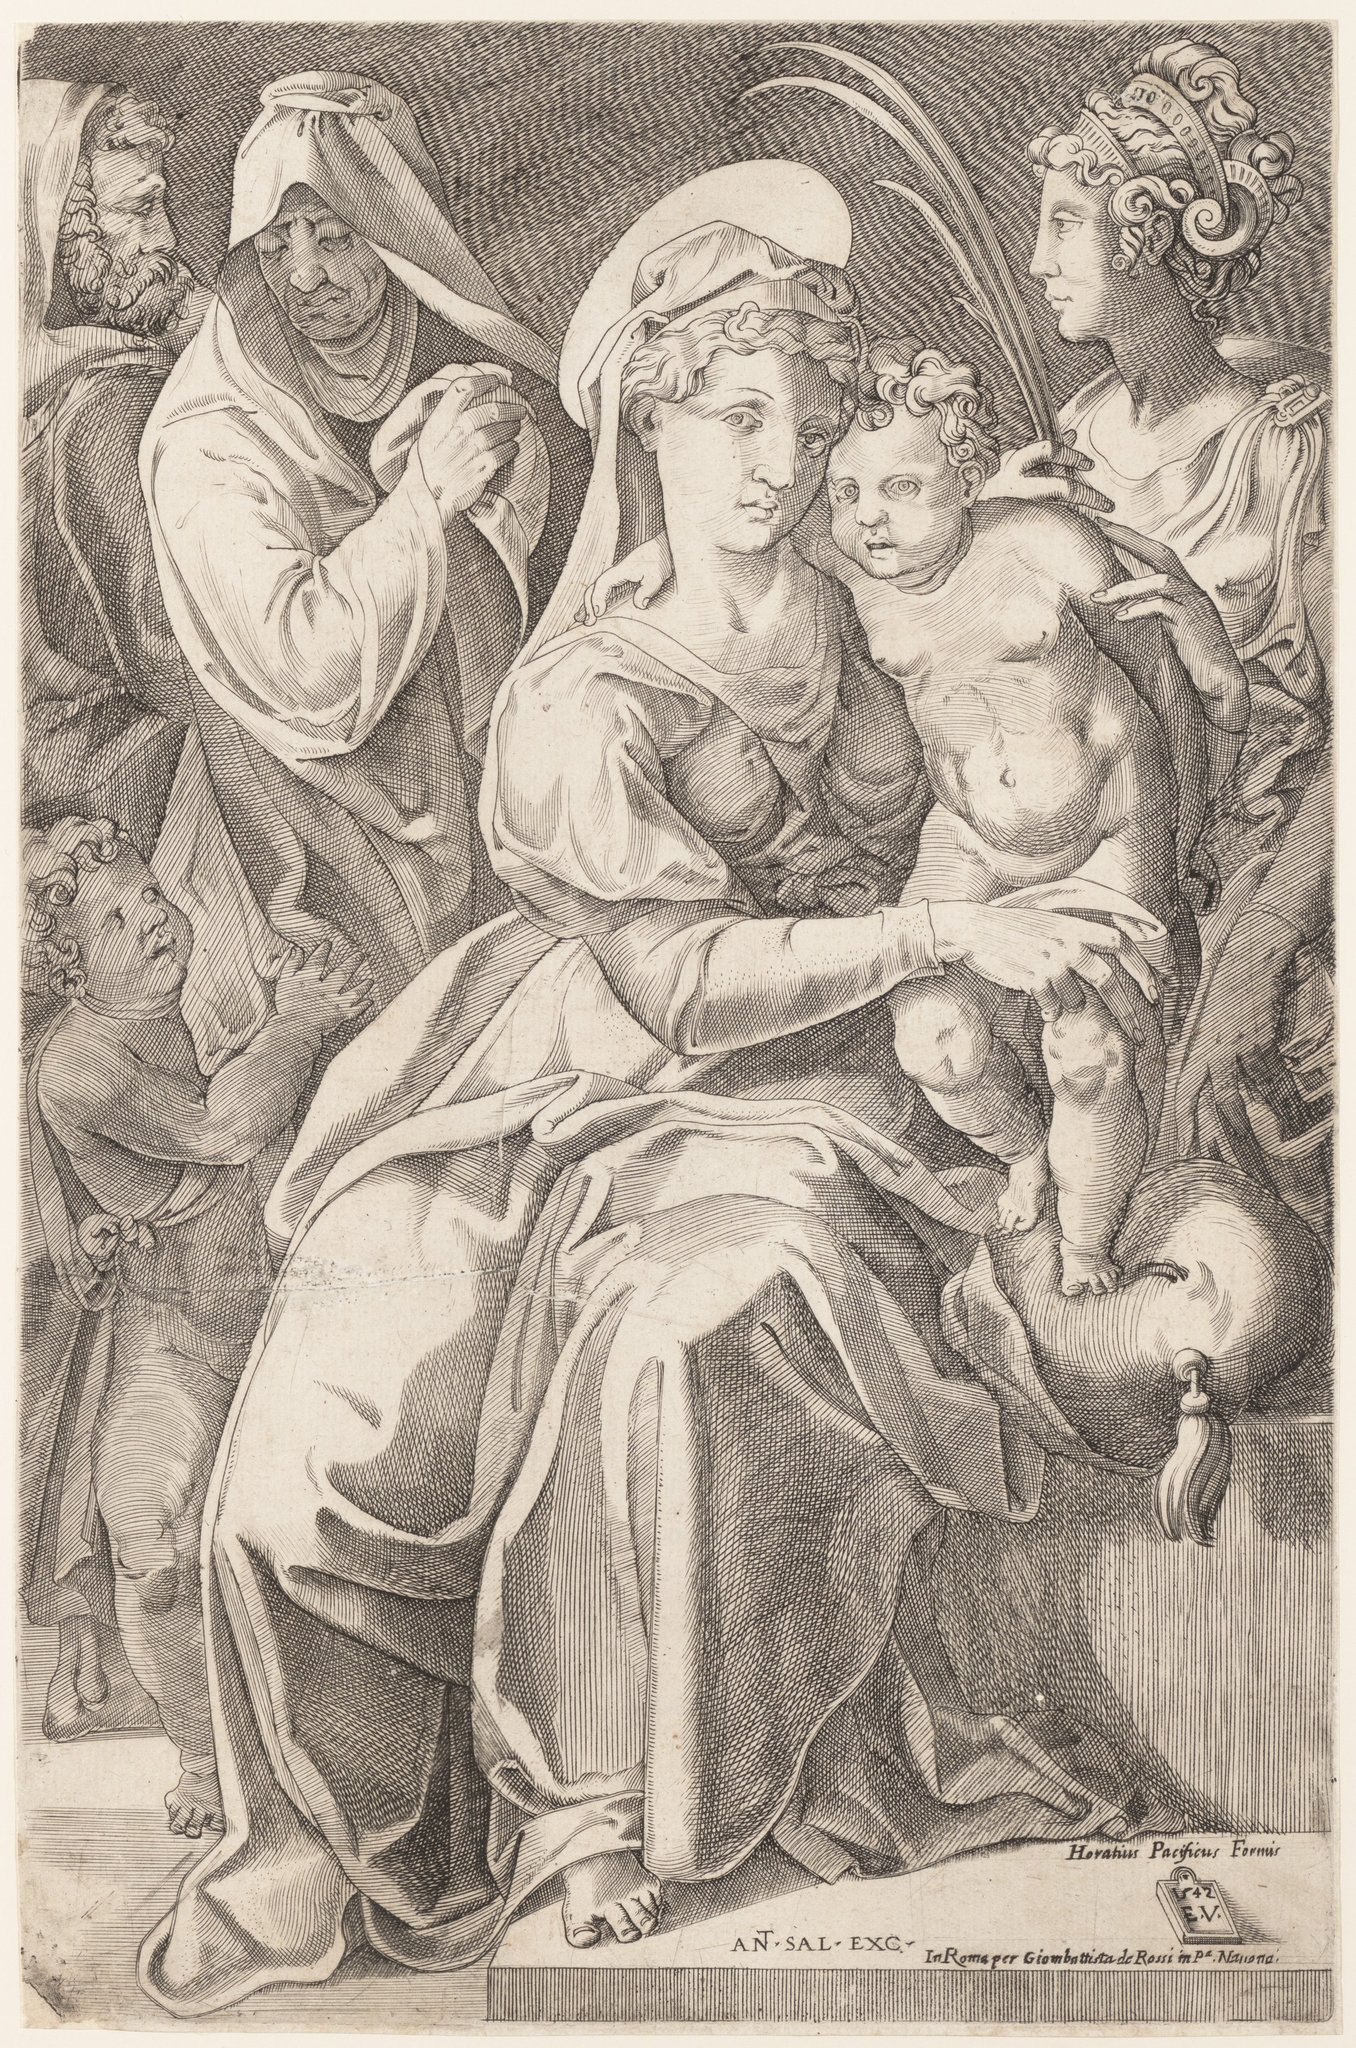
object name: print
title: The Holy Family with St. Anne and St. Catherine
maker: enea vico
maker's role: artist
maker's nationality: italian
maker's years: 1523-1567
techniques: engraving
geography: rome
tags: holy family,saint anne,saint catherine